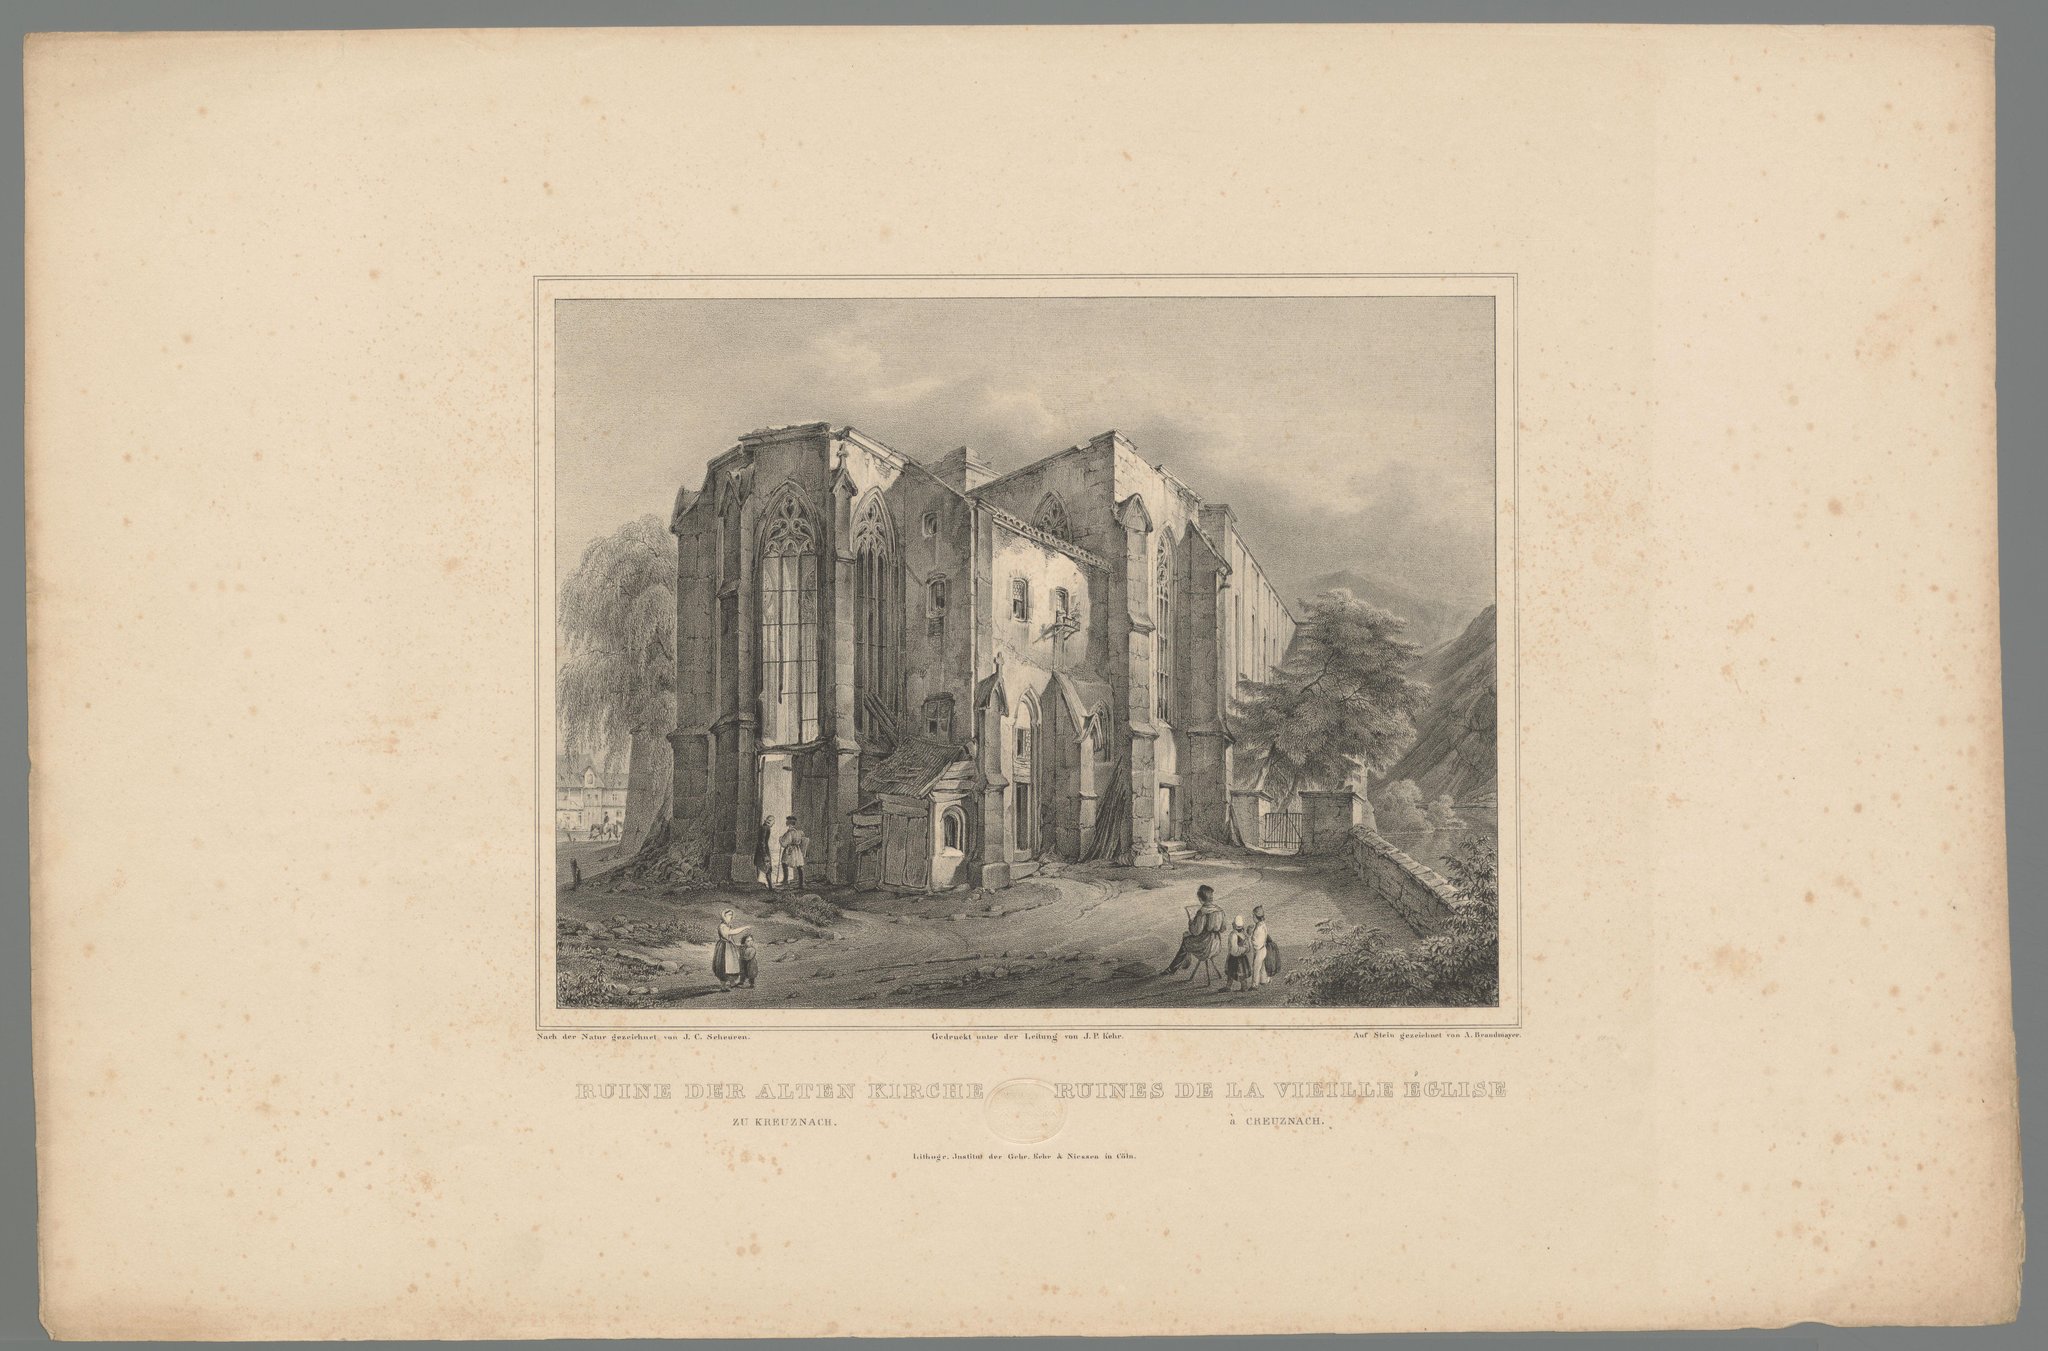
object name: print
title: Gezichten op het Nahe dal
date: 1834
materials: paper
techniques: lithograph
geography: cologne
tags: ruin of church, monastery, etc., landscape with ruins (+ city(-scape) with figures, staffage)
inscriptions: collector's mark: Lugt 2228, check stamp: ‘Verlag von L. Niessen in Cöln’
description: De serie 'Das Nahe-Thal. Von dem Ursprunge der Nahe bis zu ihrer Mündung in den Rhein' is uitgegeven in vijf delen van elk vier prenten vervaardigd door A. Brandmayer en Andreas Borum. Tien prenten uit deze serie zijn daarnaast waarschijnlijk ook nog samen onder de titel 'Kreuznach und seine Umgebung. Erinnerung an seine Heilquellen und das Nahe-Thal' uitgegeven.